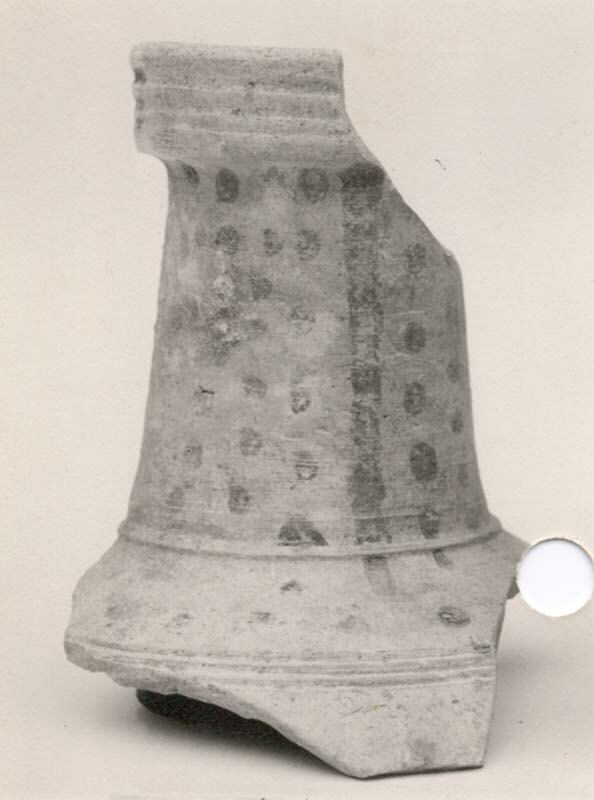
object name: jar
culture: sasanian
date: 201-700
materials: ceramic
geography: mesopotamia